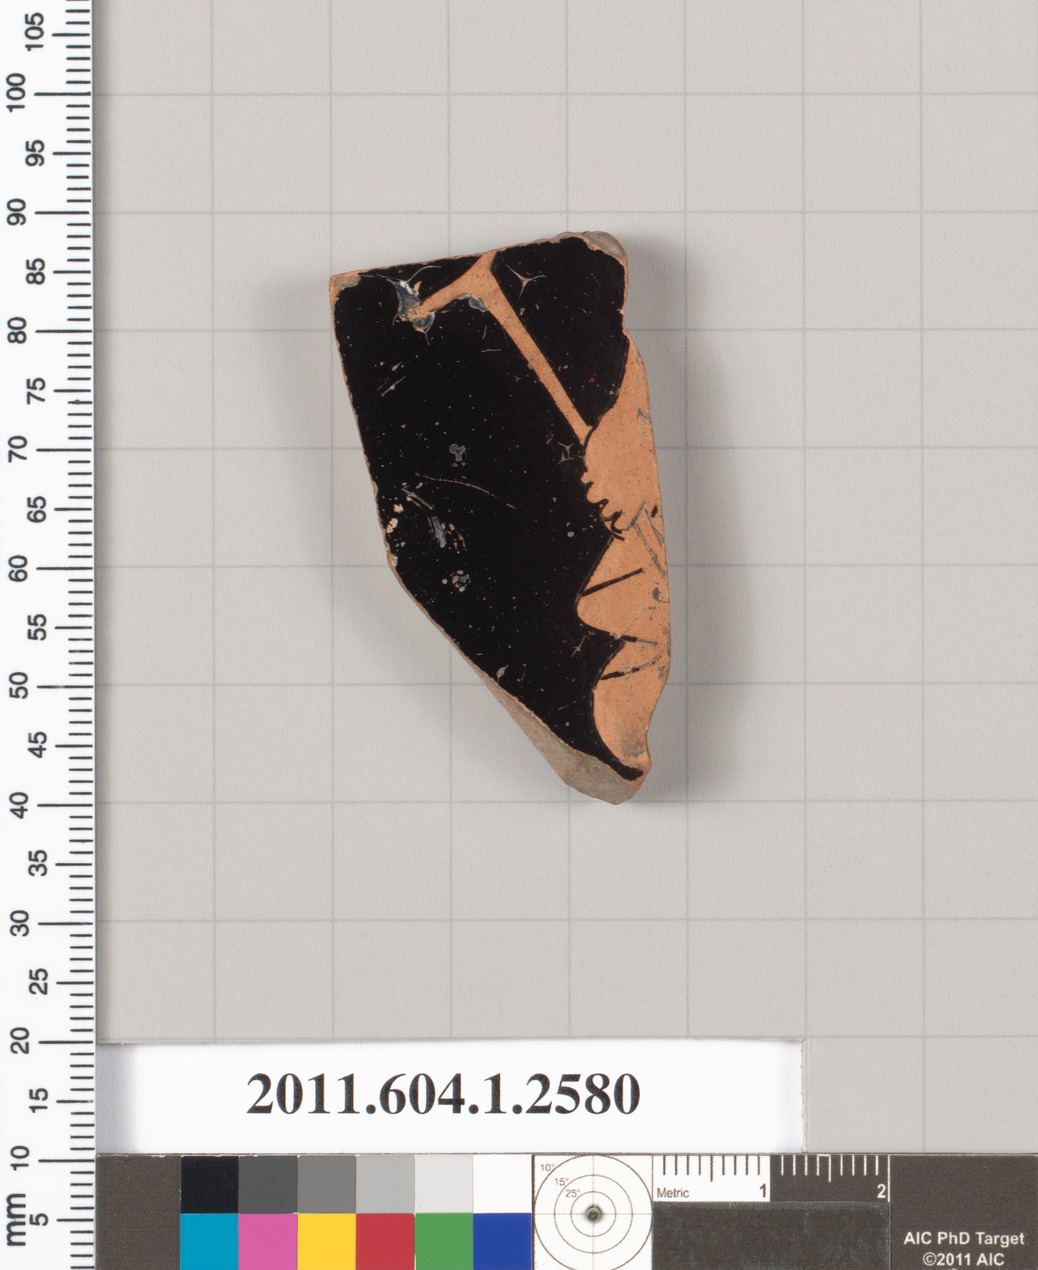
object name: kylix fragment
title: Terracotta fragment of a kylix (drinking cup)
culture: greek, attic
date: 490-480 BCE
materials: terracotta